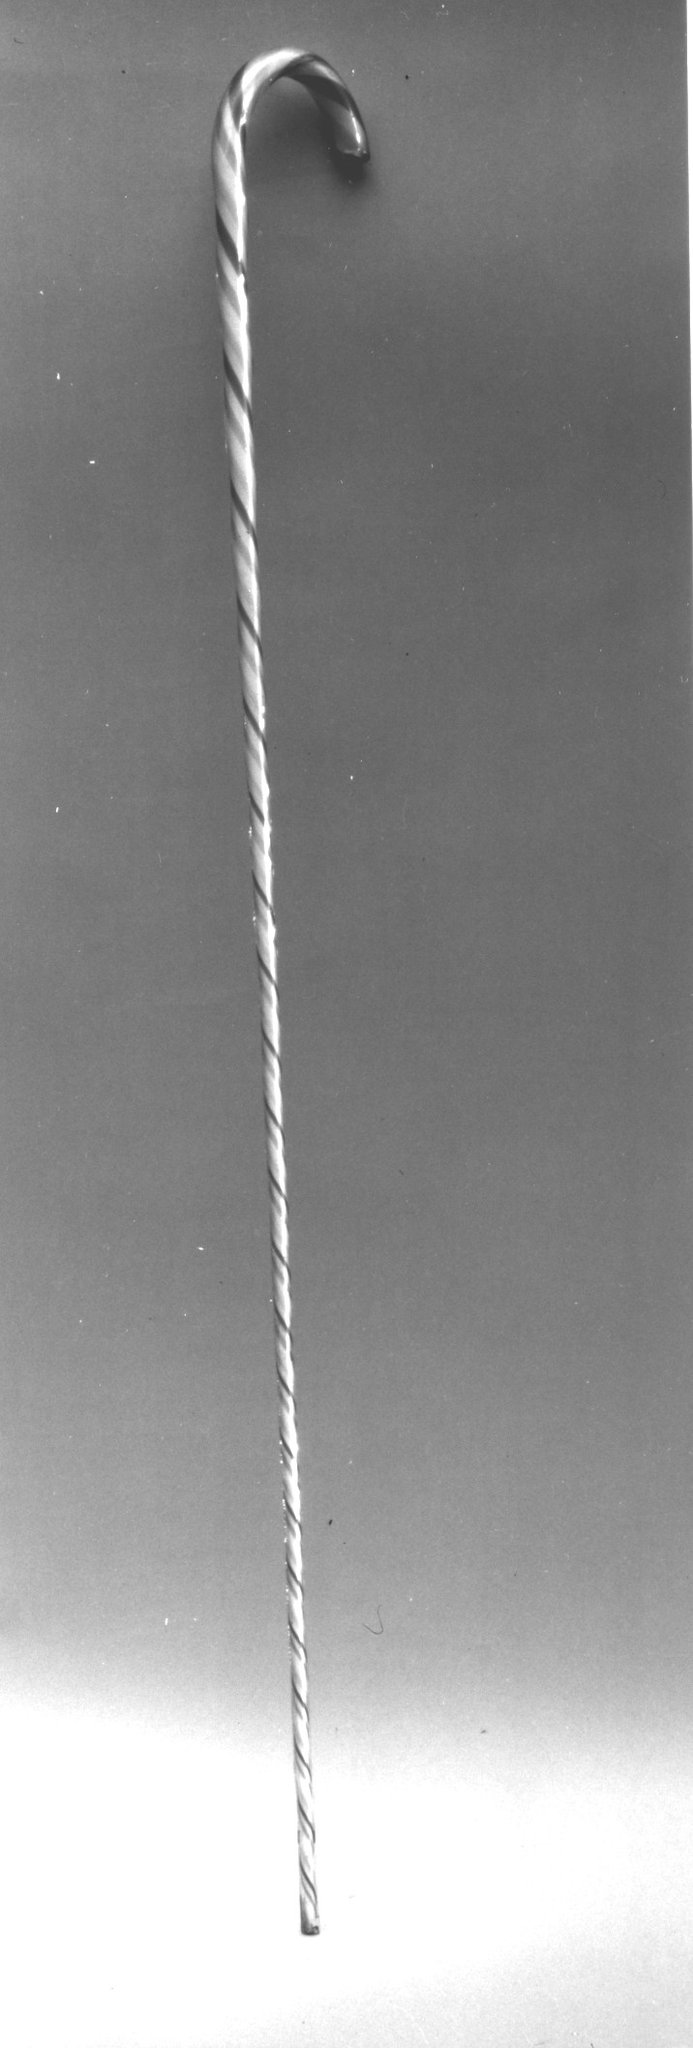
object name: cane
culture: american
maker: dorflinger glass works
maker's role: maker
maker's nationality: american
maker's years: 1865-1881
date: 1865-1921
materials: glass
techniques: glassblowing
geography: united states